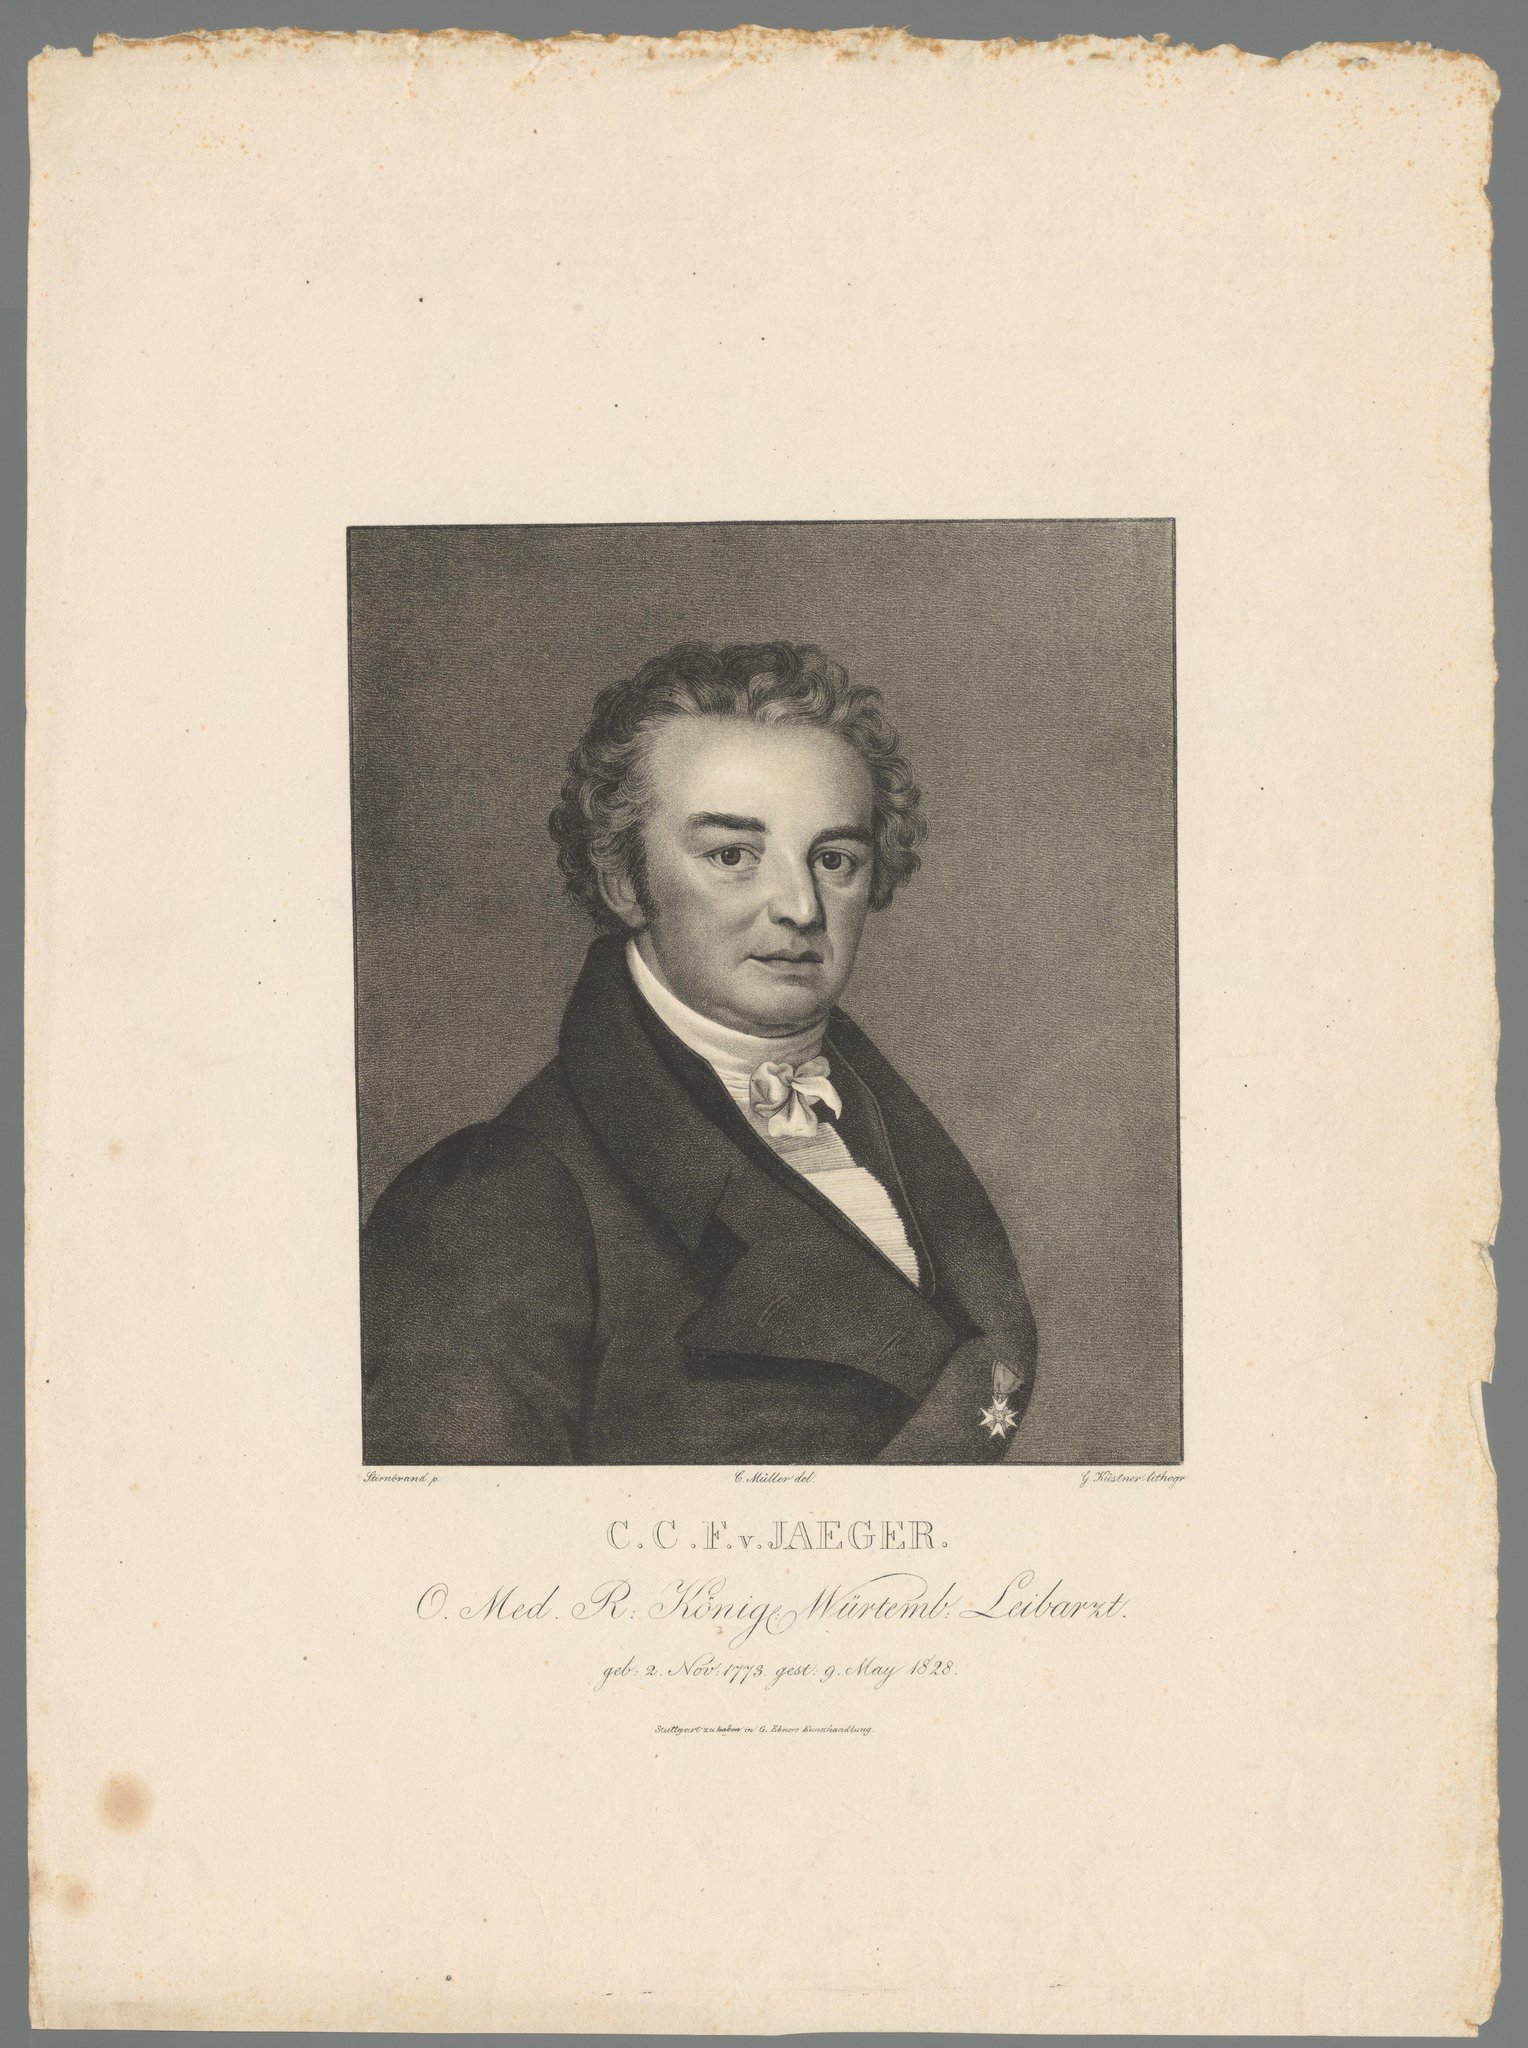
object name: print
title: C.C.F. v. Jaeger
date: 1810-1864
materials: paper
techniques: lithograph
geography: stuttgart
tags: adult man, historical persons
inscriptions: collector's mark: Lugt 2228